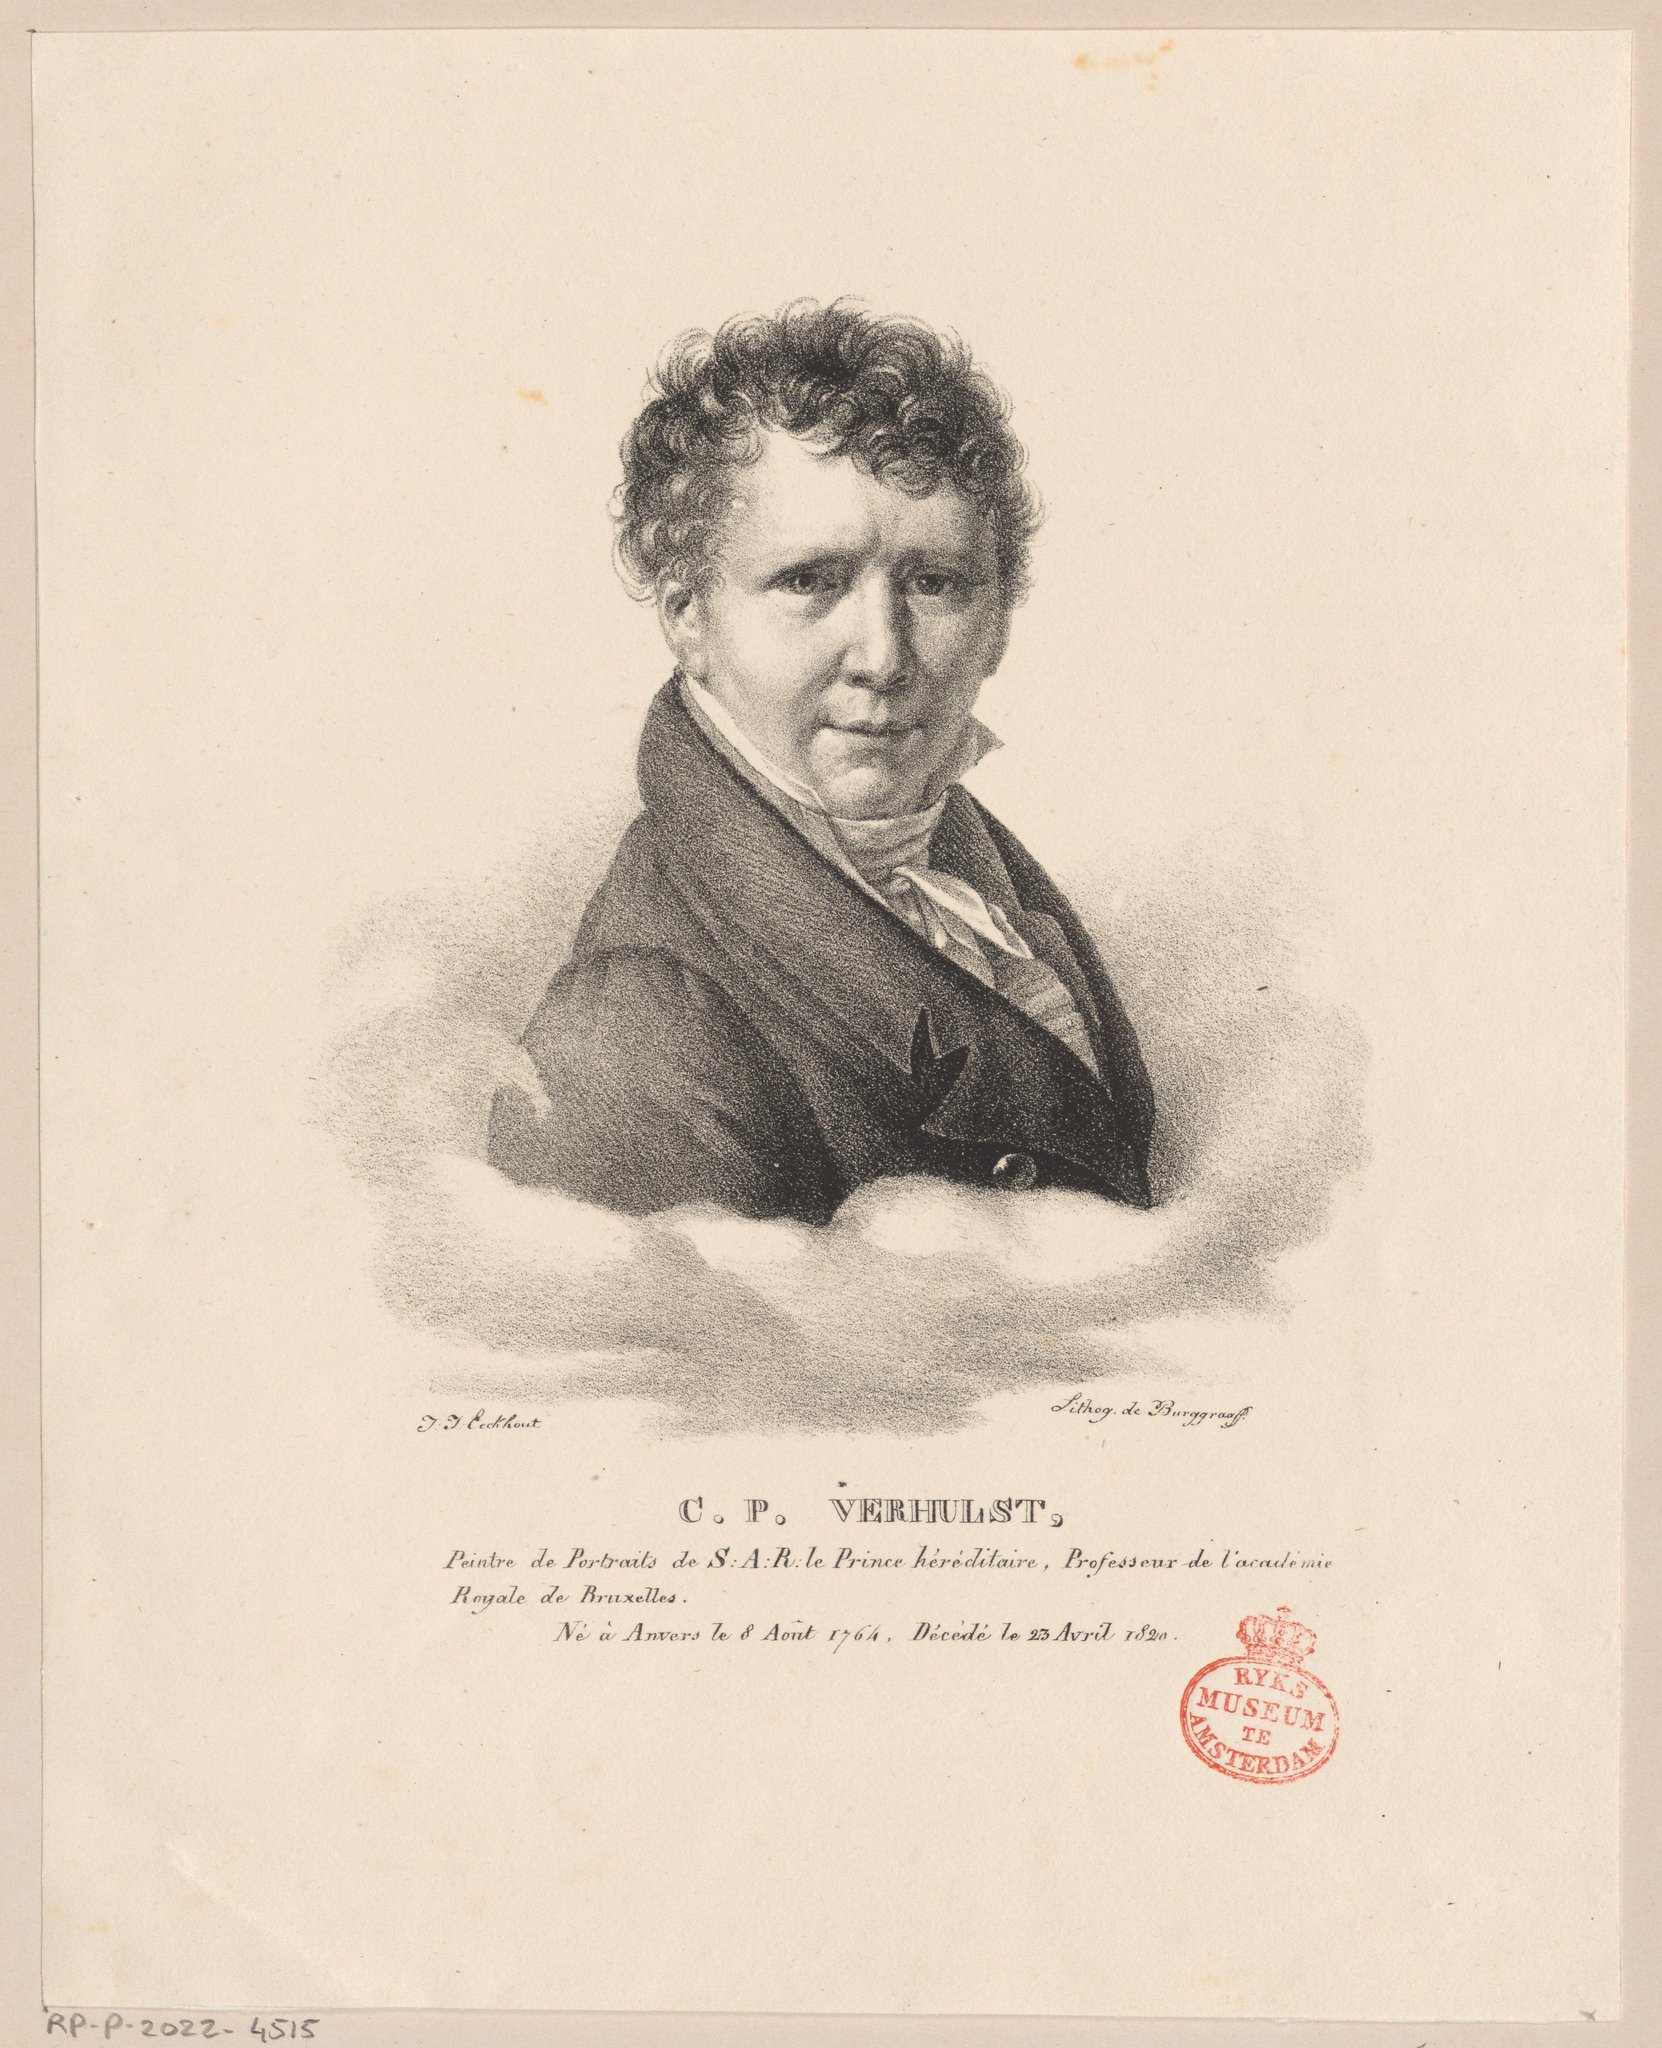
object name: print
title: Portraits des artistes modernes nés dans le Royaume des Pays-Bas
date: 1822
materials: paper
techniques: lithograph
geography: brussels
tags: mechelen, brussels, painter, artist, charles pièrre verhulst, historical persons, portrait, self-portrait of painter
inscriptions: collector's mark: Lugt 12